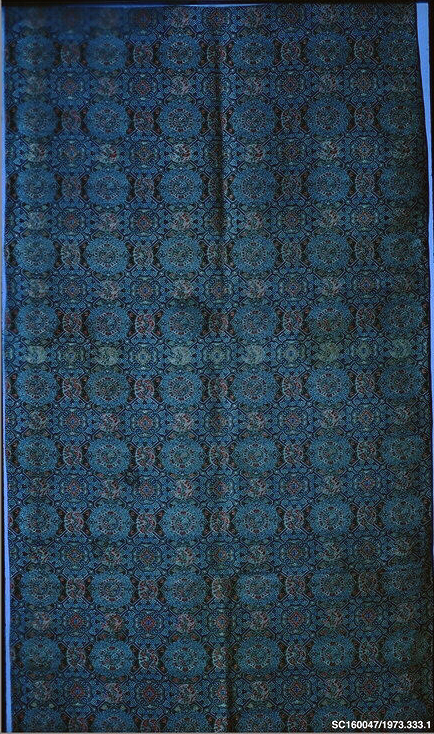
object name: panel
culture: chinese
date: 1701-1800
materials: silk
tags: flowers